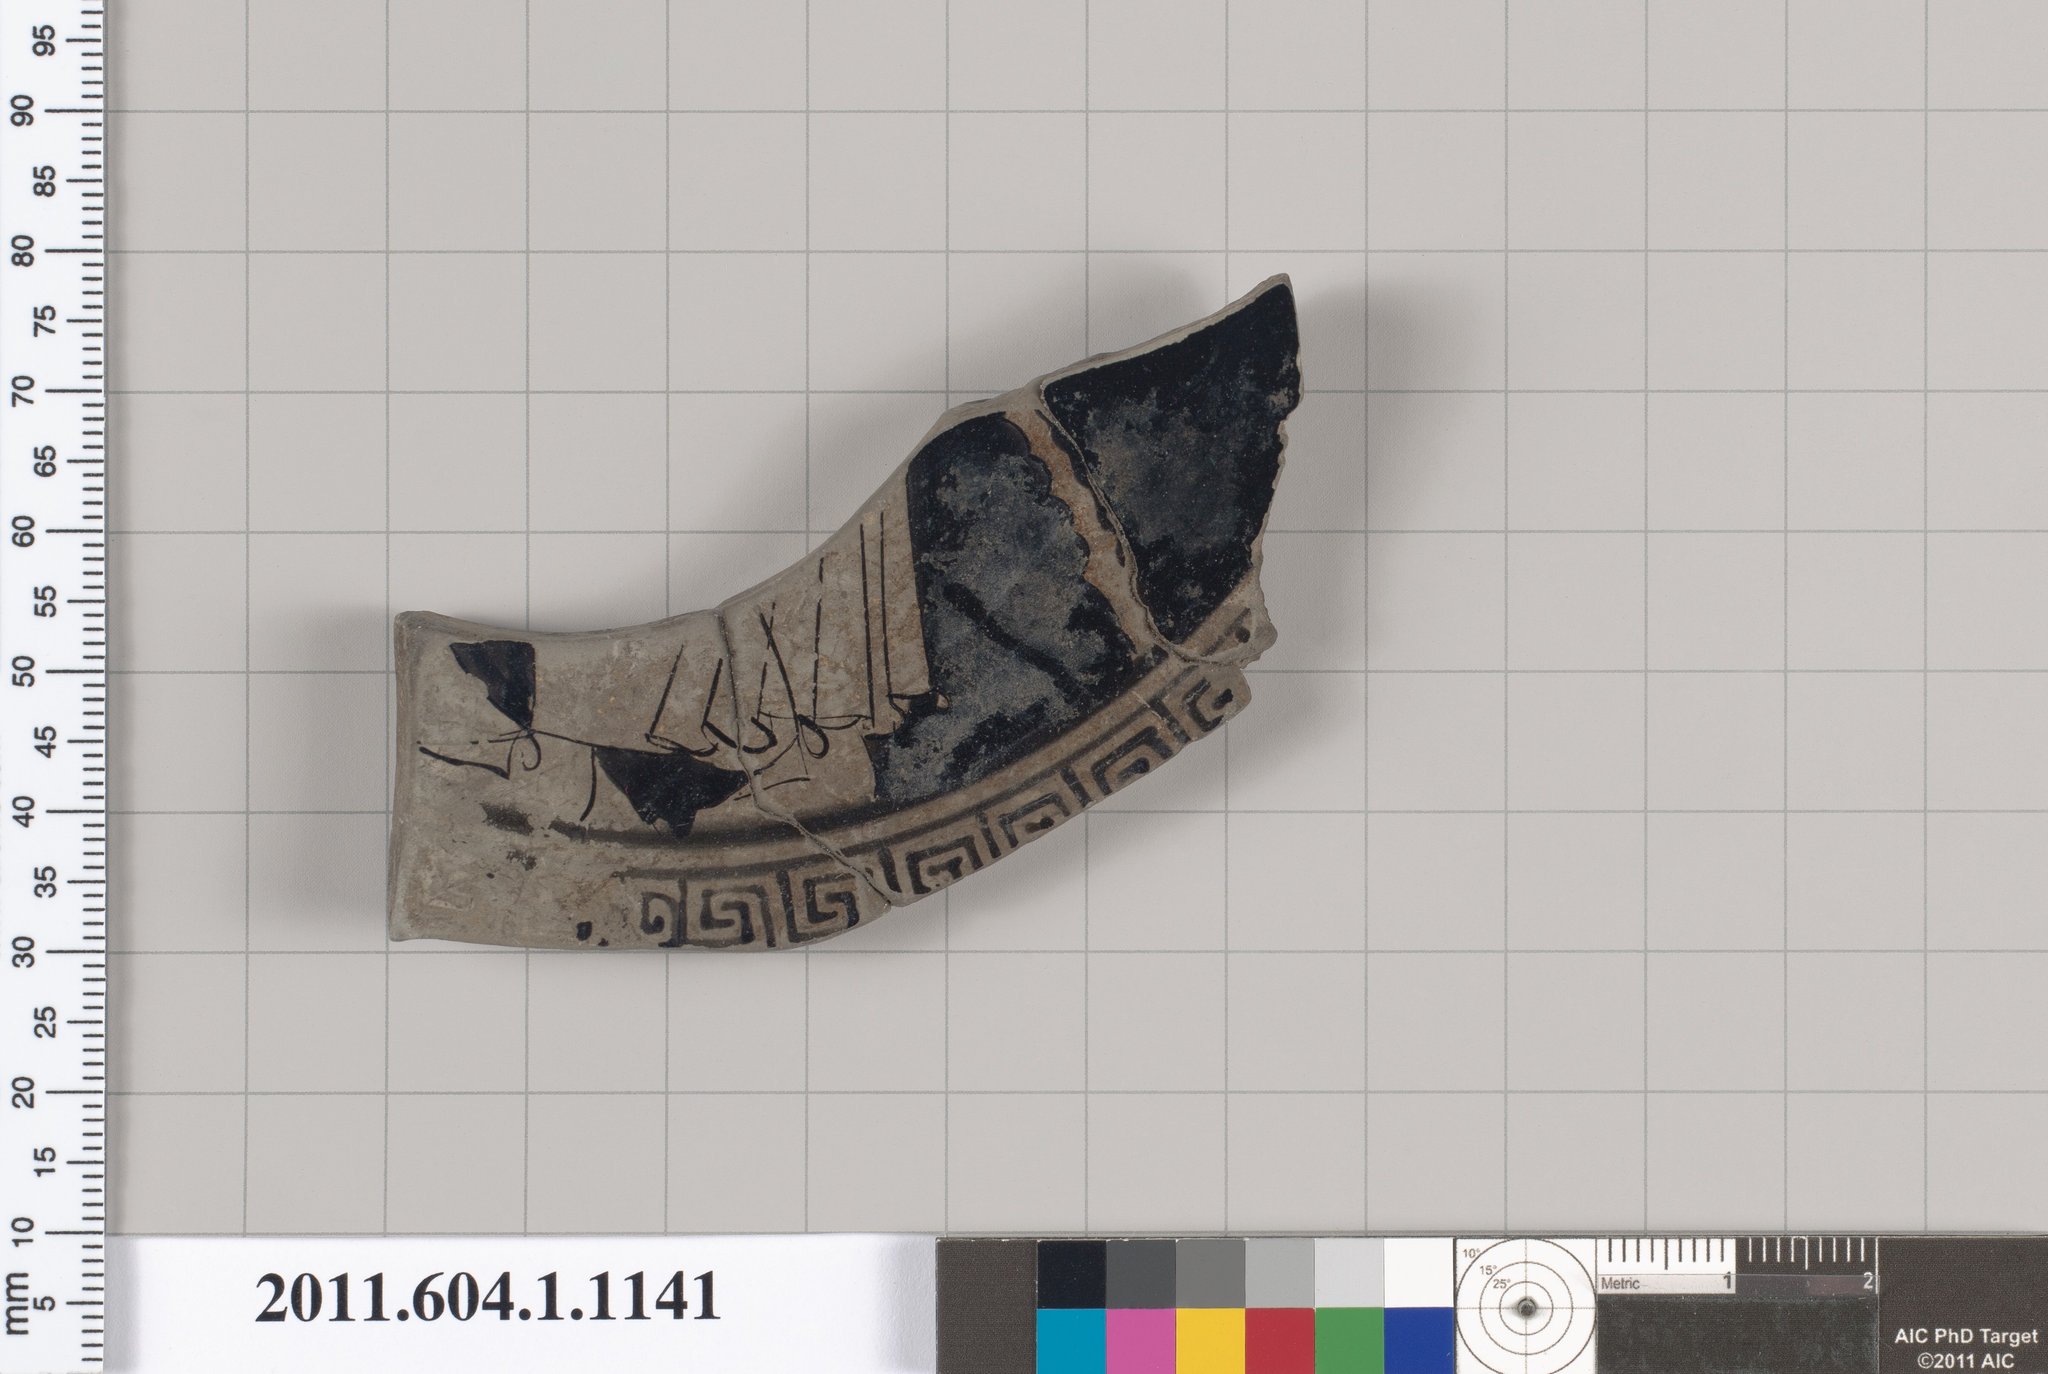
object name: kylix fragment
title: Terracotta fragment of a kylix (drinking cup)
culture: greek, attic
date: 475-451 BCE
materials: terracotta